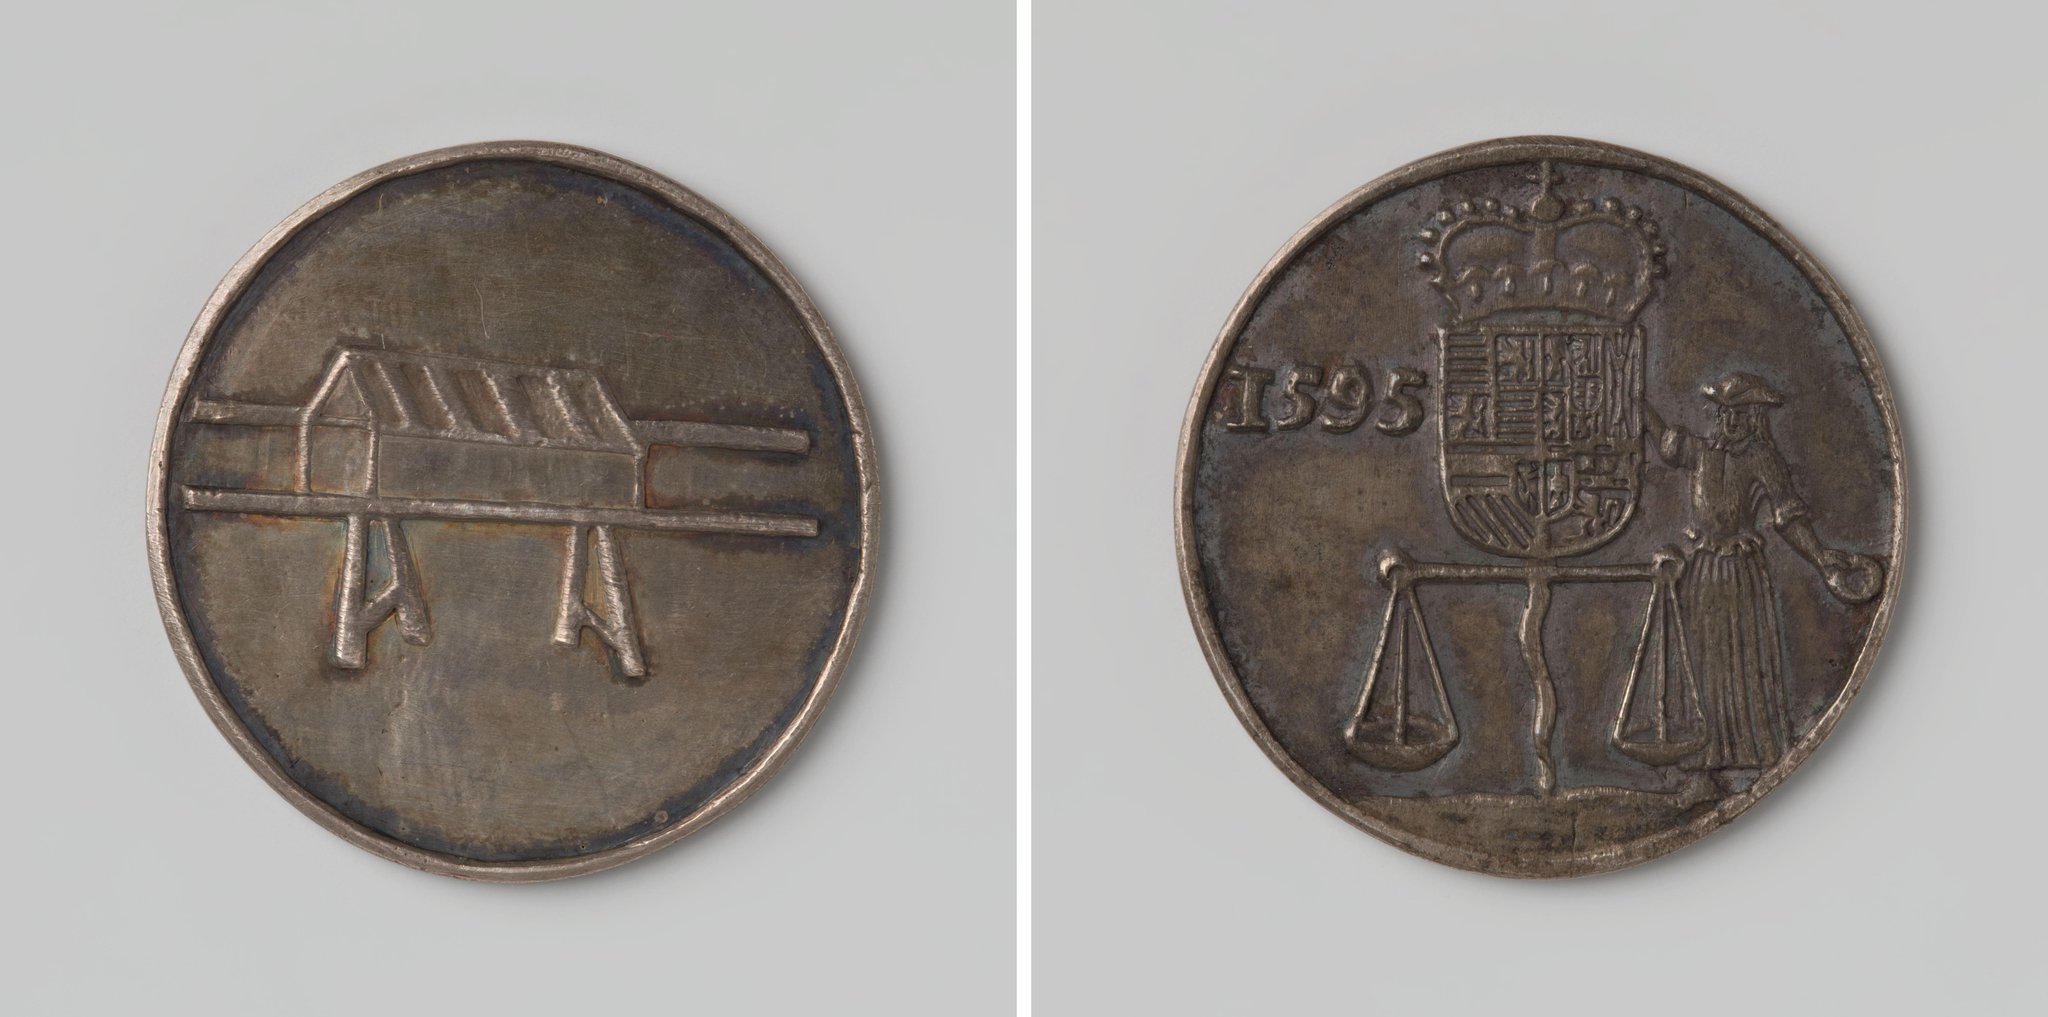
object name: jeton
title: Overlijden van Ernst, aartshertog van Oostenrijk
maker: Anonymous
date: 1595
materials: silver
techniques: striking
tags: vienna, brussels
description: Zilveren penning. Voorzijde: doodkist staande op lijkbaar. Keerzijde: gekroond wapenschild, met rechterhand vastgehouden door vrouw met hoed op hoofd en krans in andere hand; links van wapenschild: jaartal, onder wapenschild: weegschaal in evenwicht